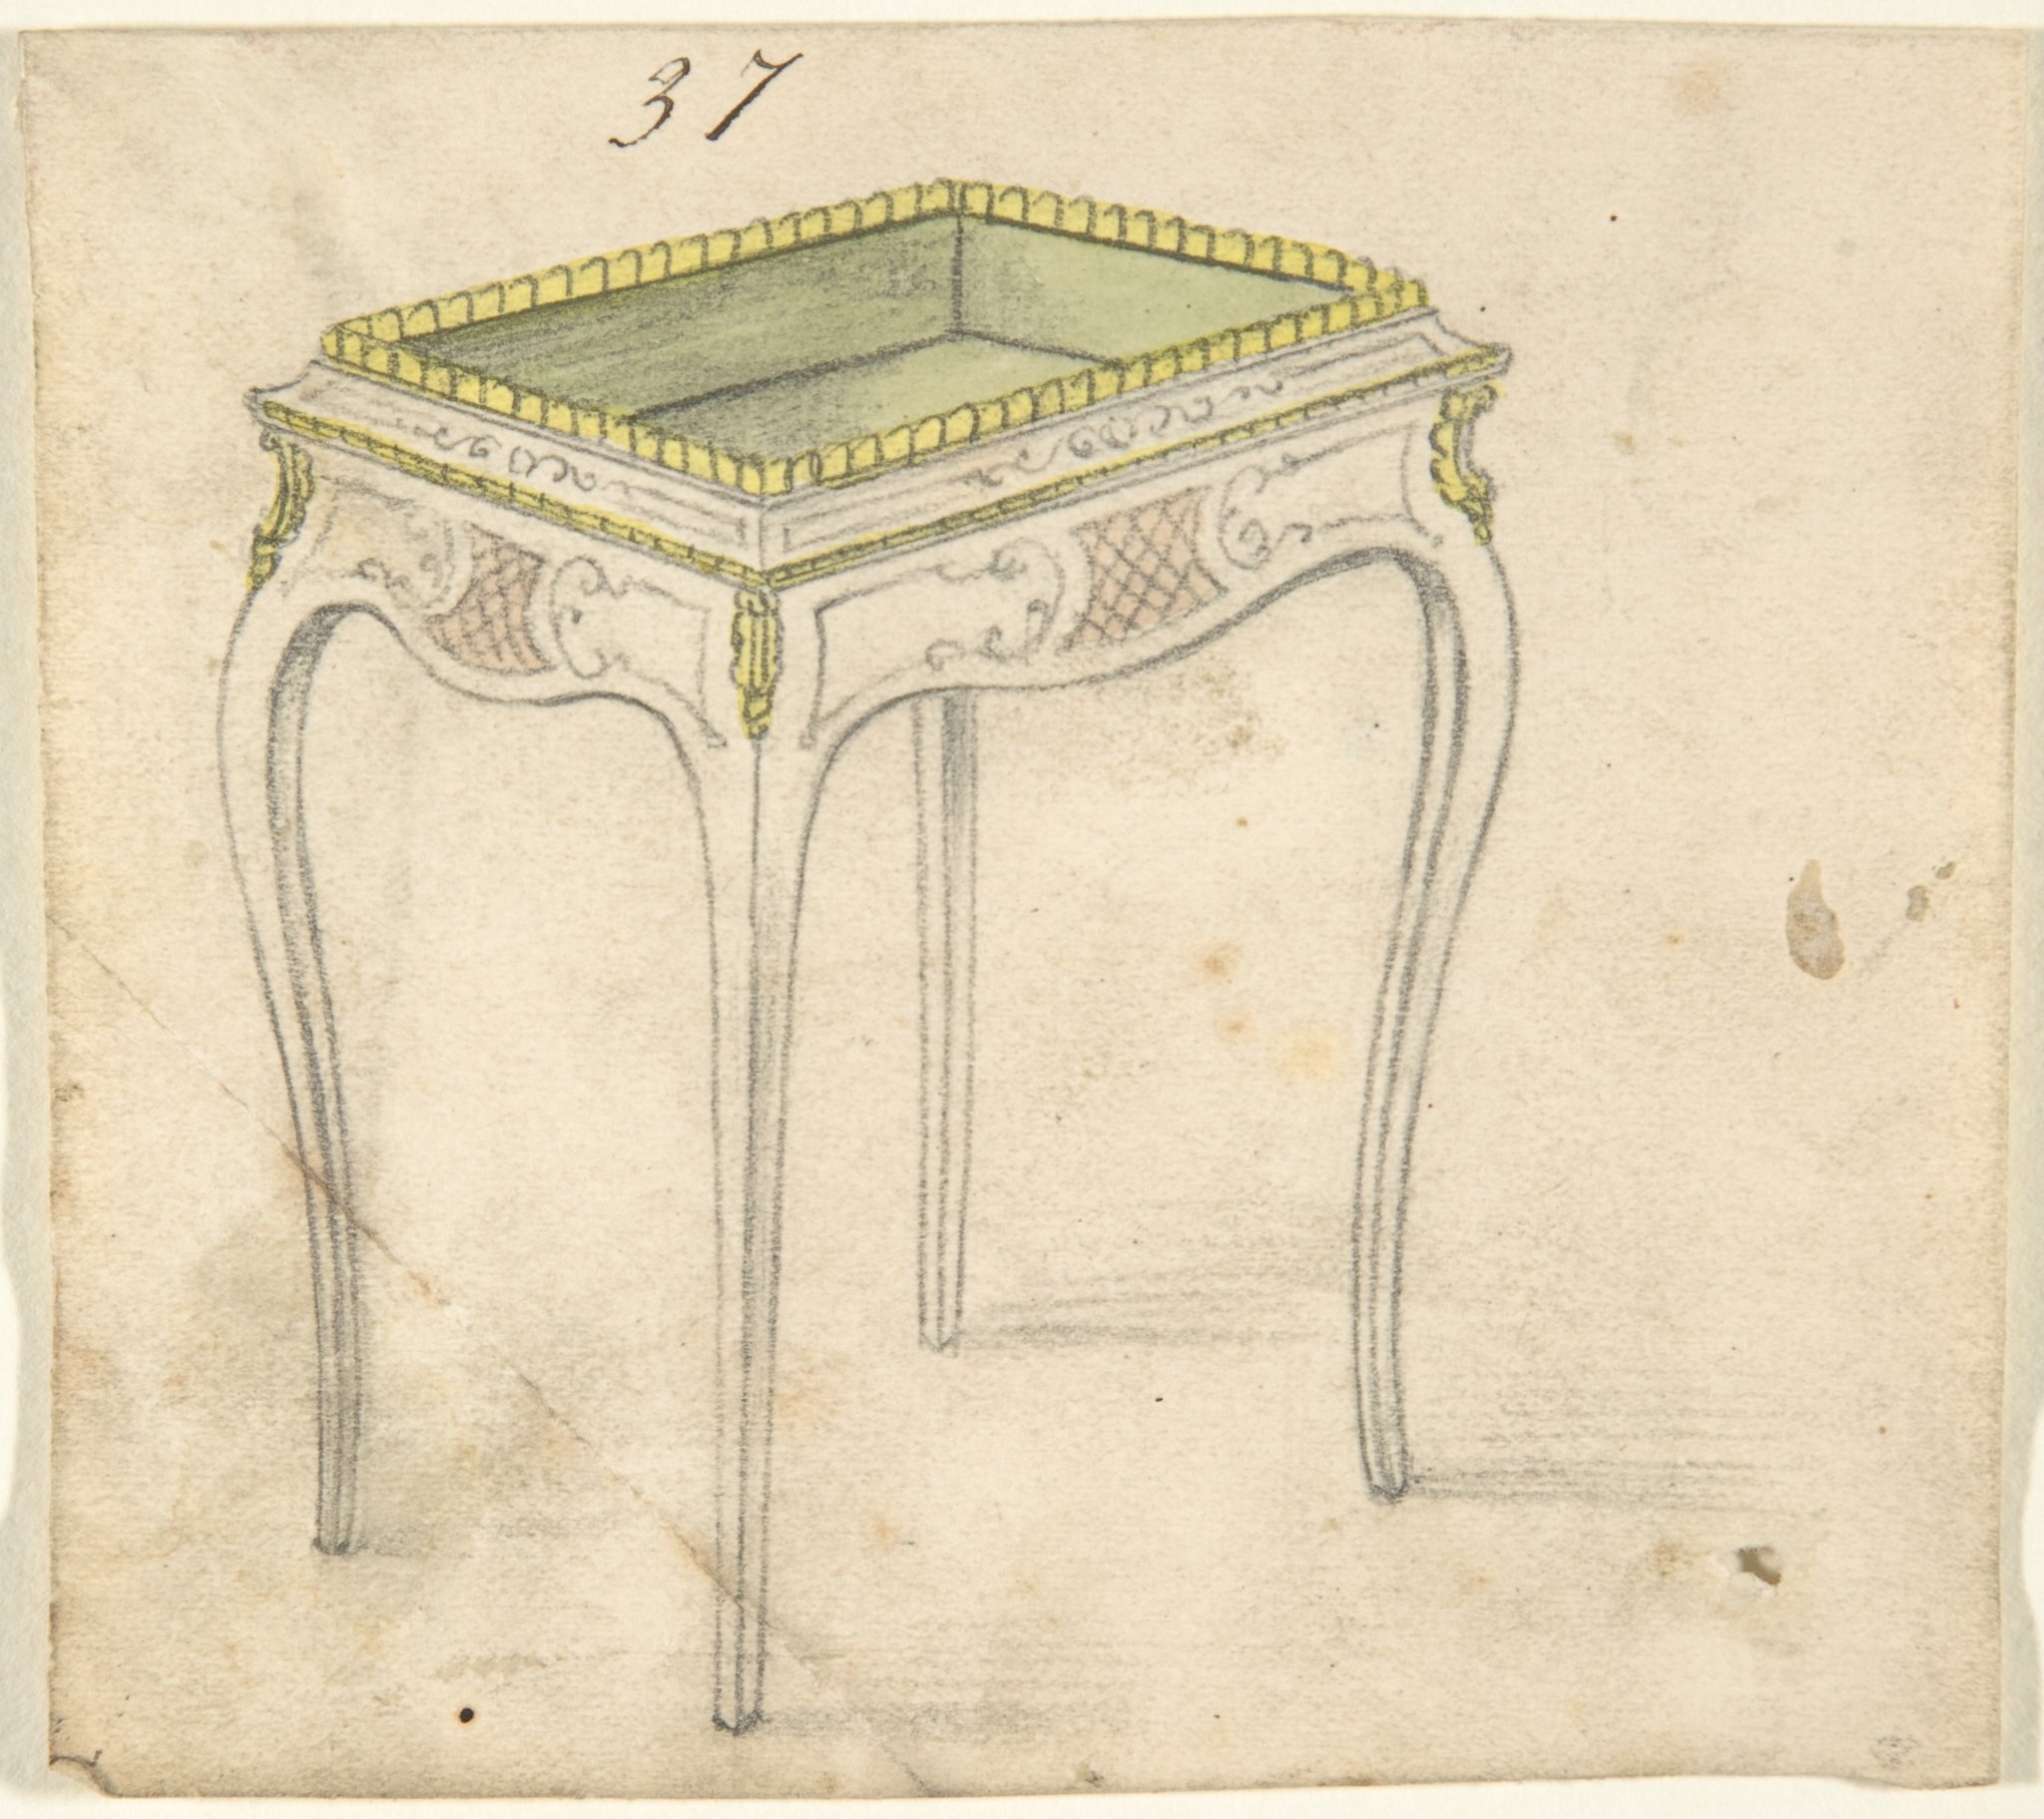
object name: drawing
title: Design for a Small Hollow-topped Table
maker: anonymous, british, 19th century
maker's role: artist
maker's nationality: british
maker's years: 1800-1900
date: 1801-1900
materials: graphite, ink, watercolor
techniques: pen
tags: tables